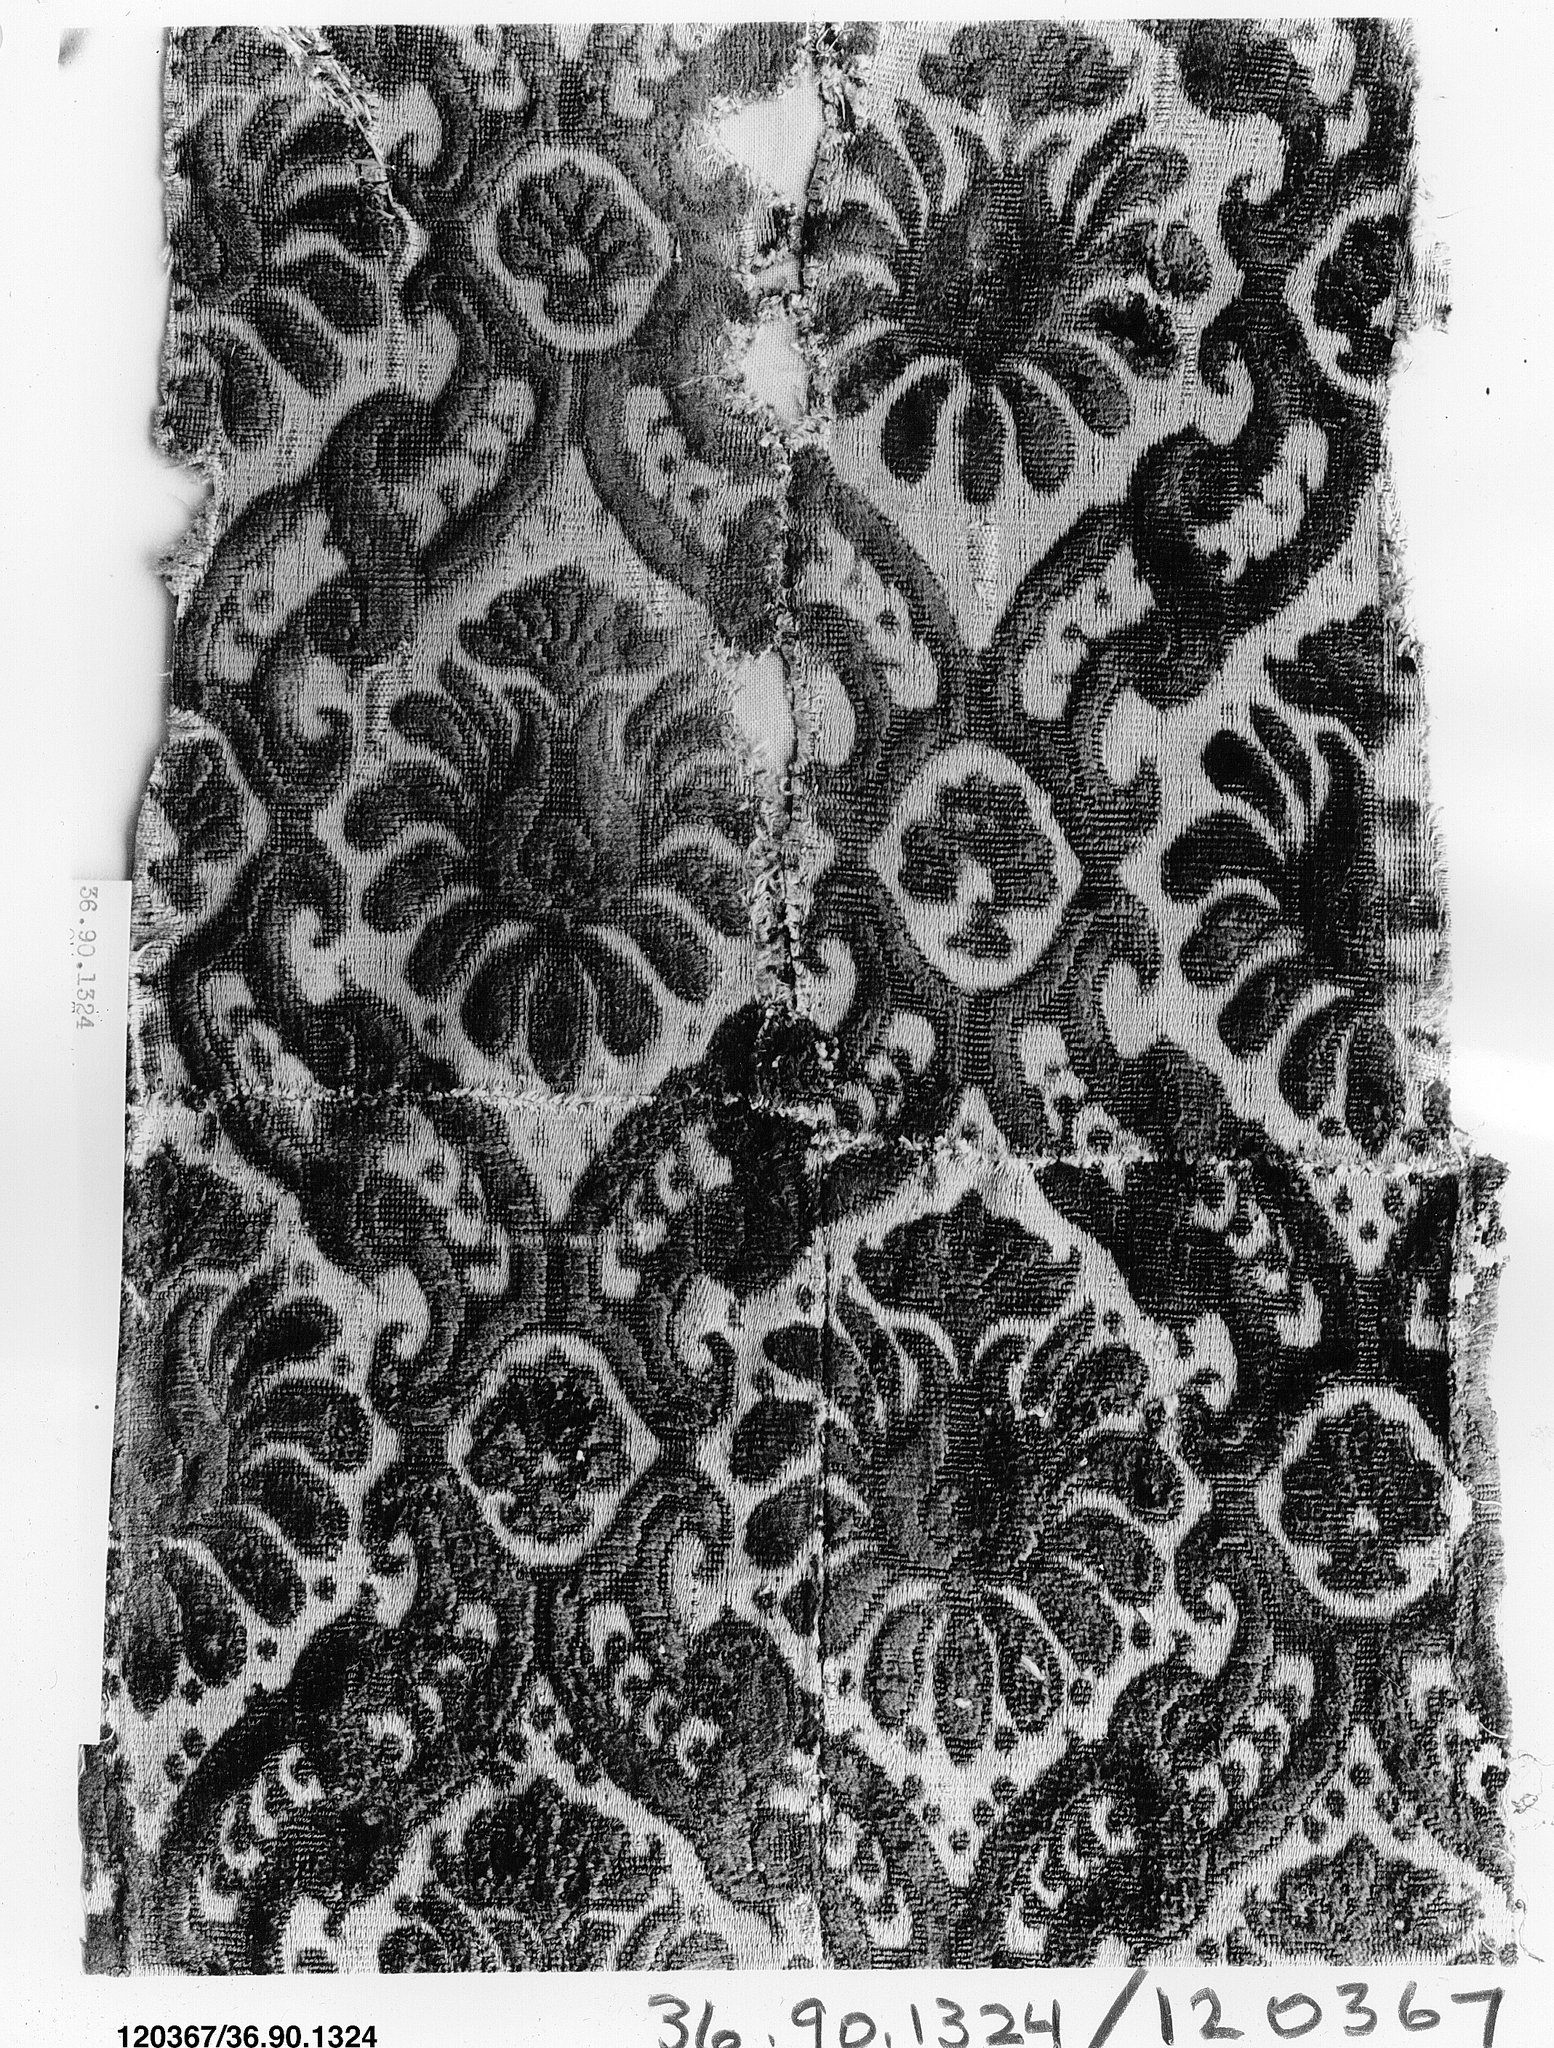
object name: piece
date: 1501-1700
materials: silk